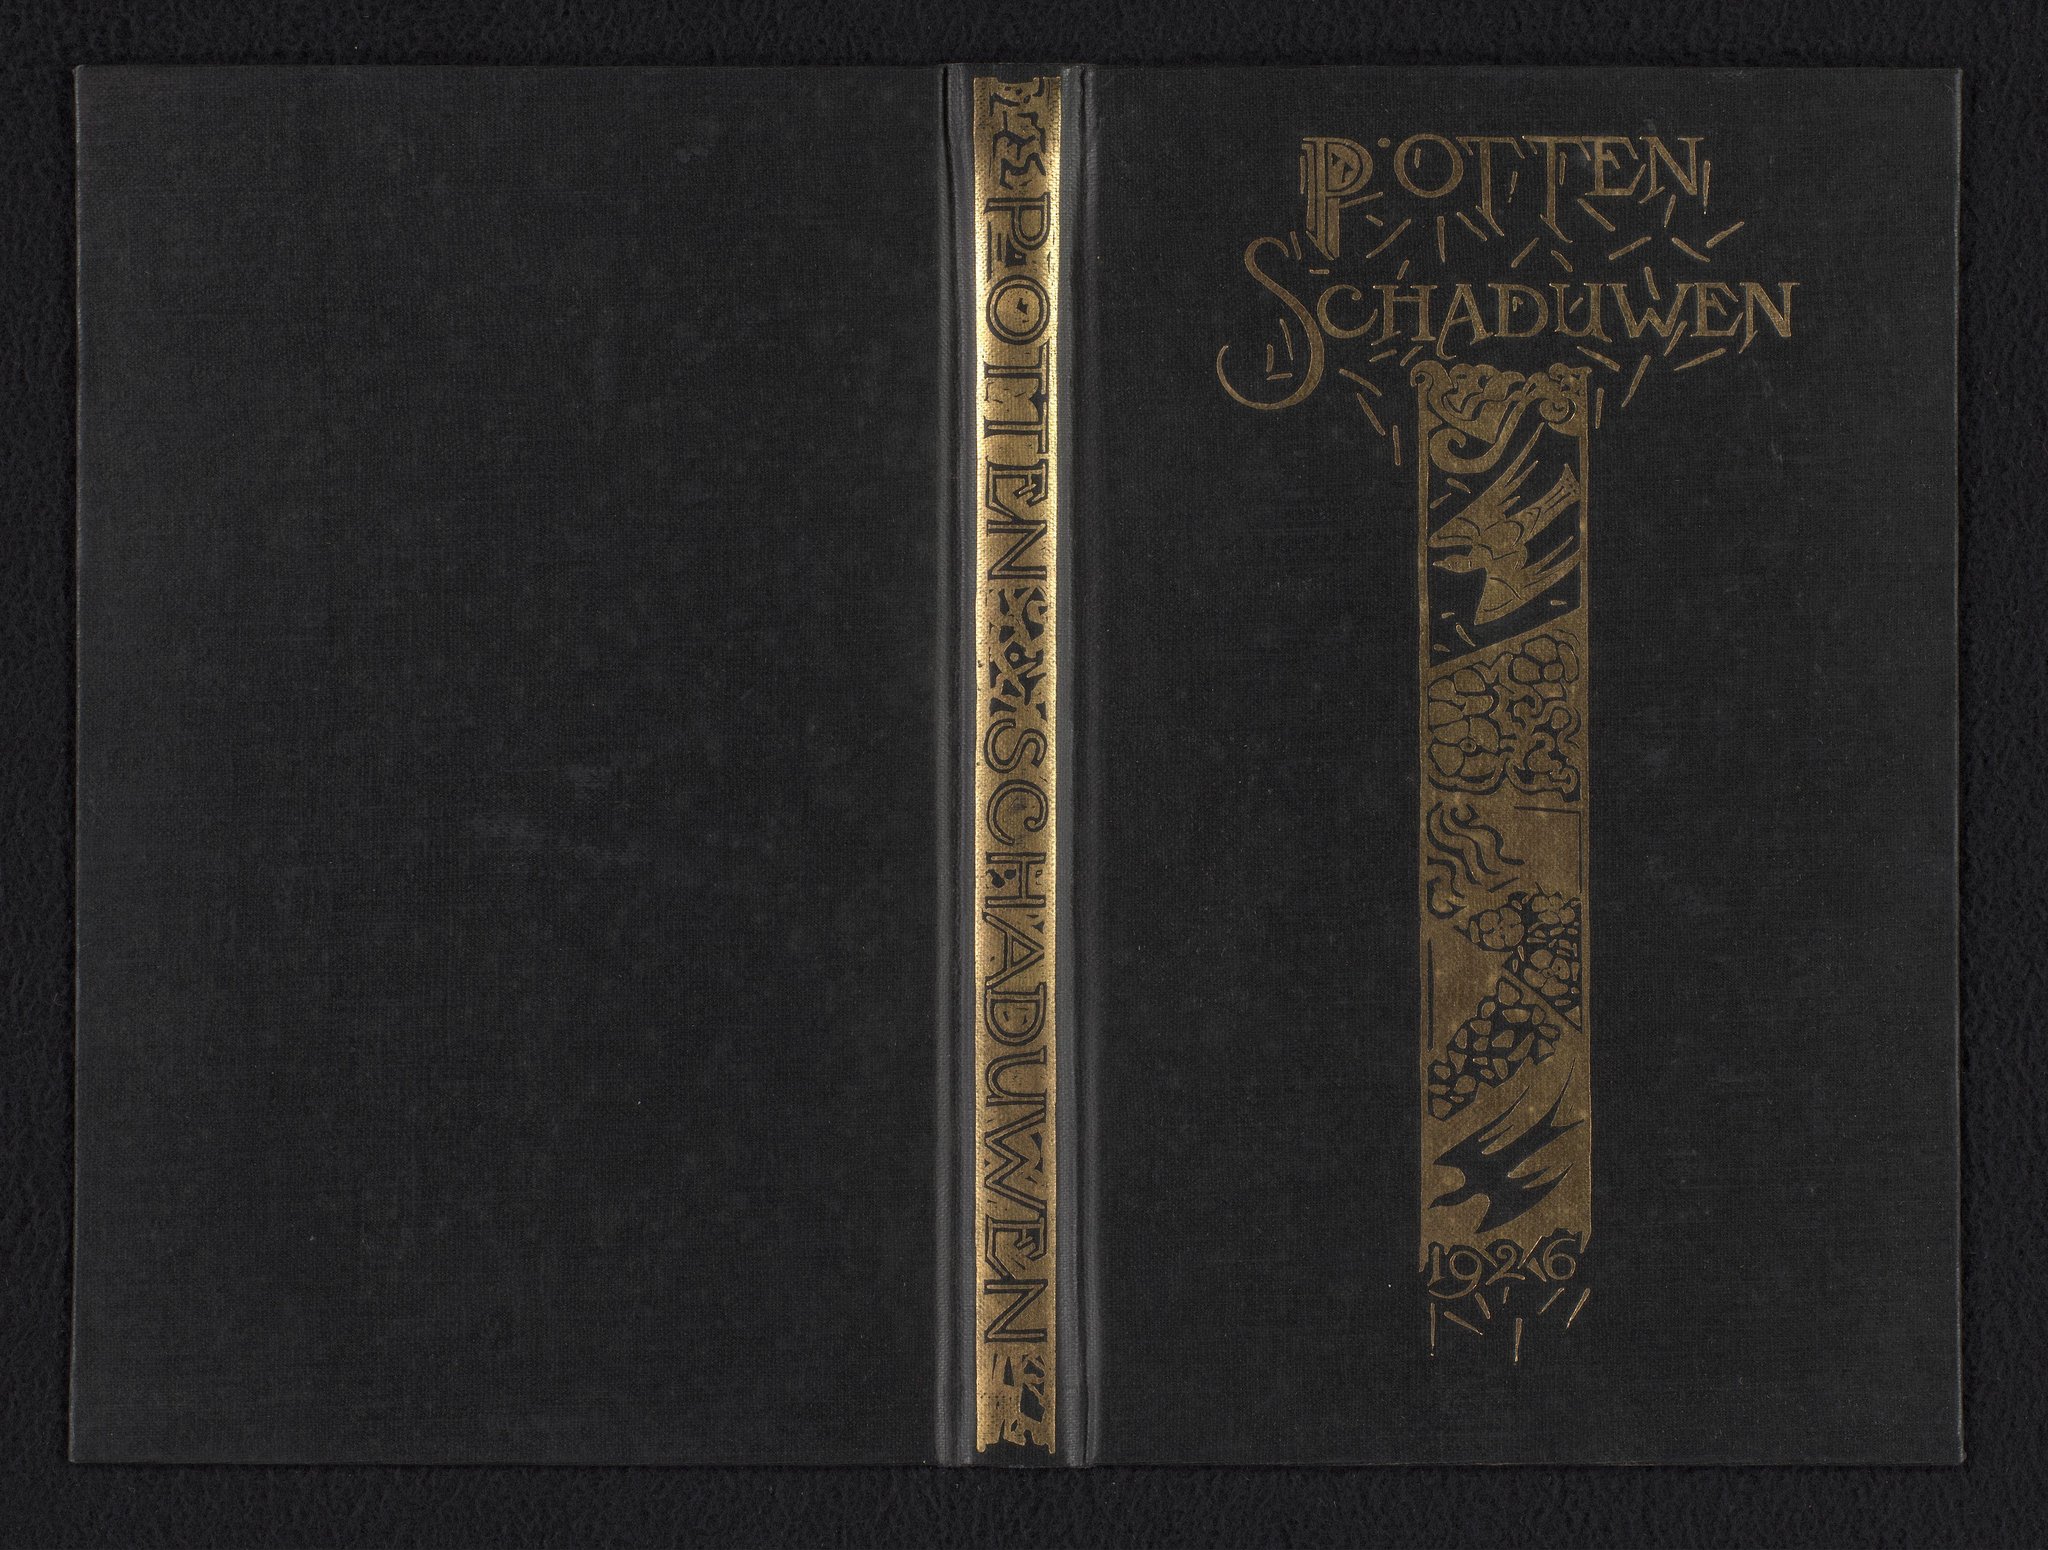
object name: binding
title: Boekband voor: P. Otten, Schaduwen, 1926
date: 1926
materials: cardboard, linen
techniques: printing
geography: rotterdam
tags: amsterdam, book-cover, binding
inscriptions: date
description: Boekband voor: Otten, P. Schaduwen. Rotterdam: W.L. & J. Brusse, 1926.